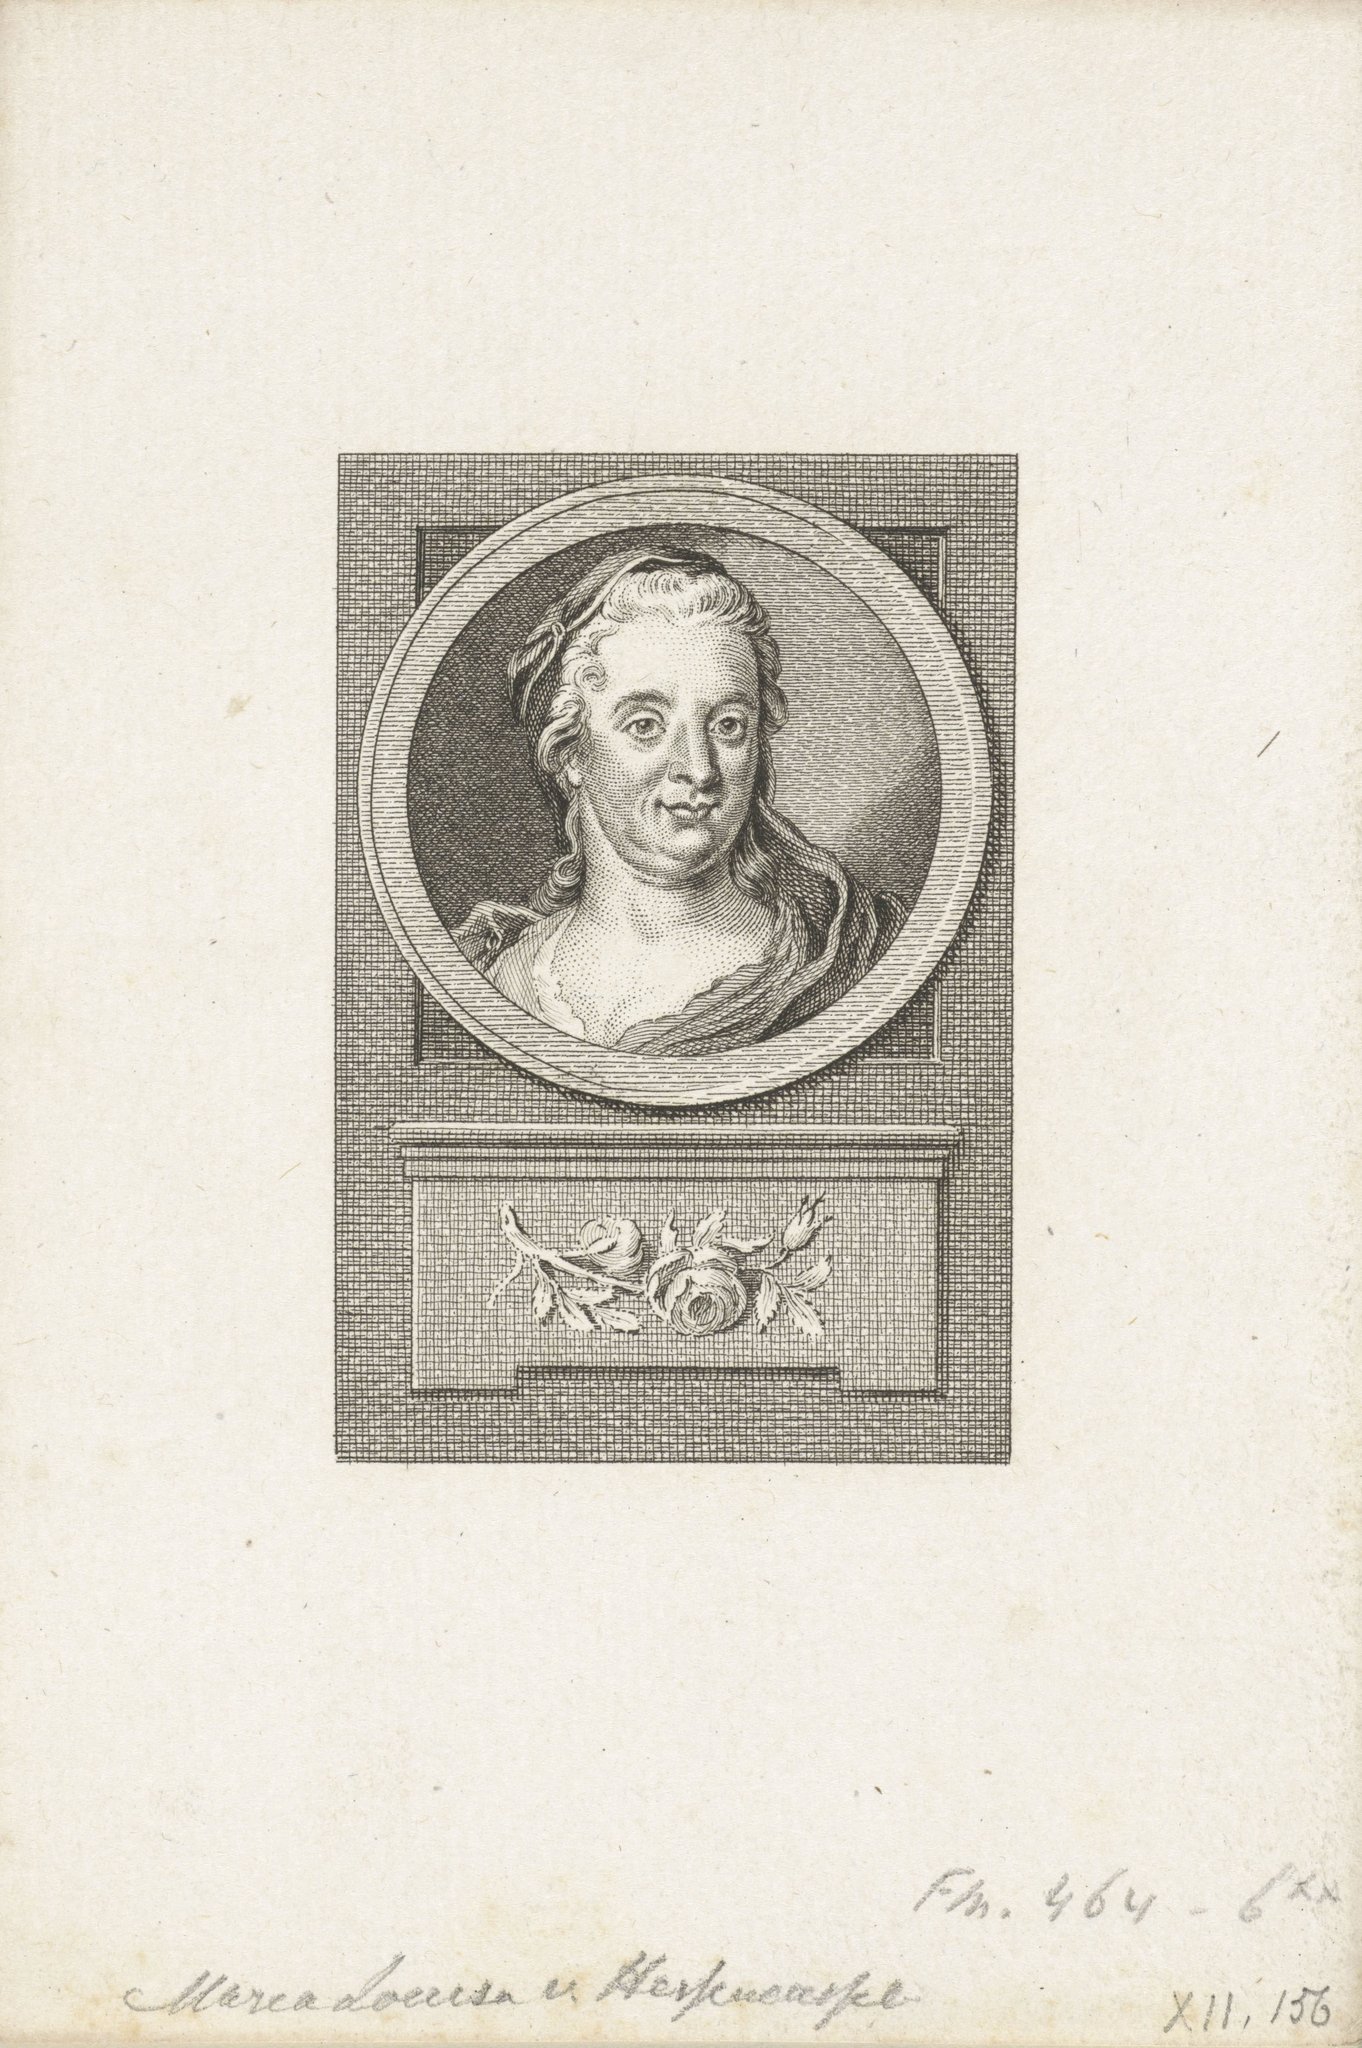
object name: print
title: Portret van Maria Louisa van Hessen-Kassel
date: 1771-1816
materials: paper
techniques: engraving, etching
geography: amsterdam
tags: kassel, leeuwarden, maria louisa van hessen-kassel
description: Portret van Maria Louisa in een cirkel. Op een voetstuk een roos.